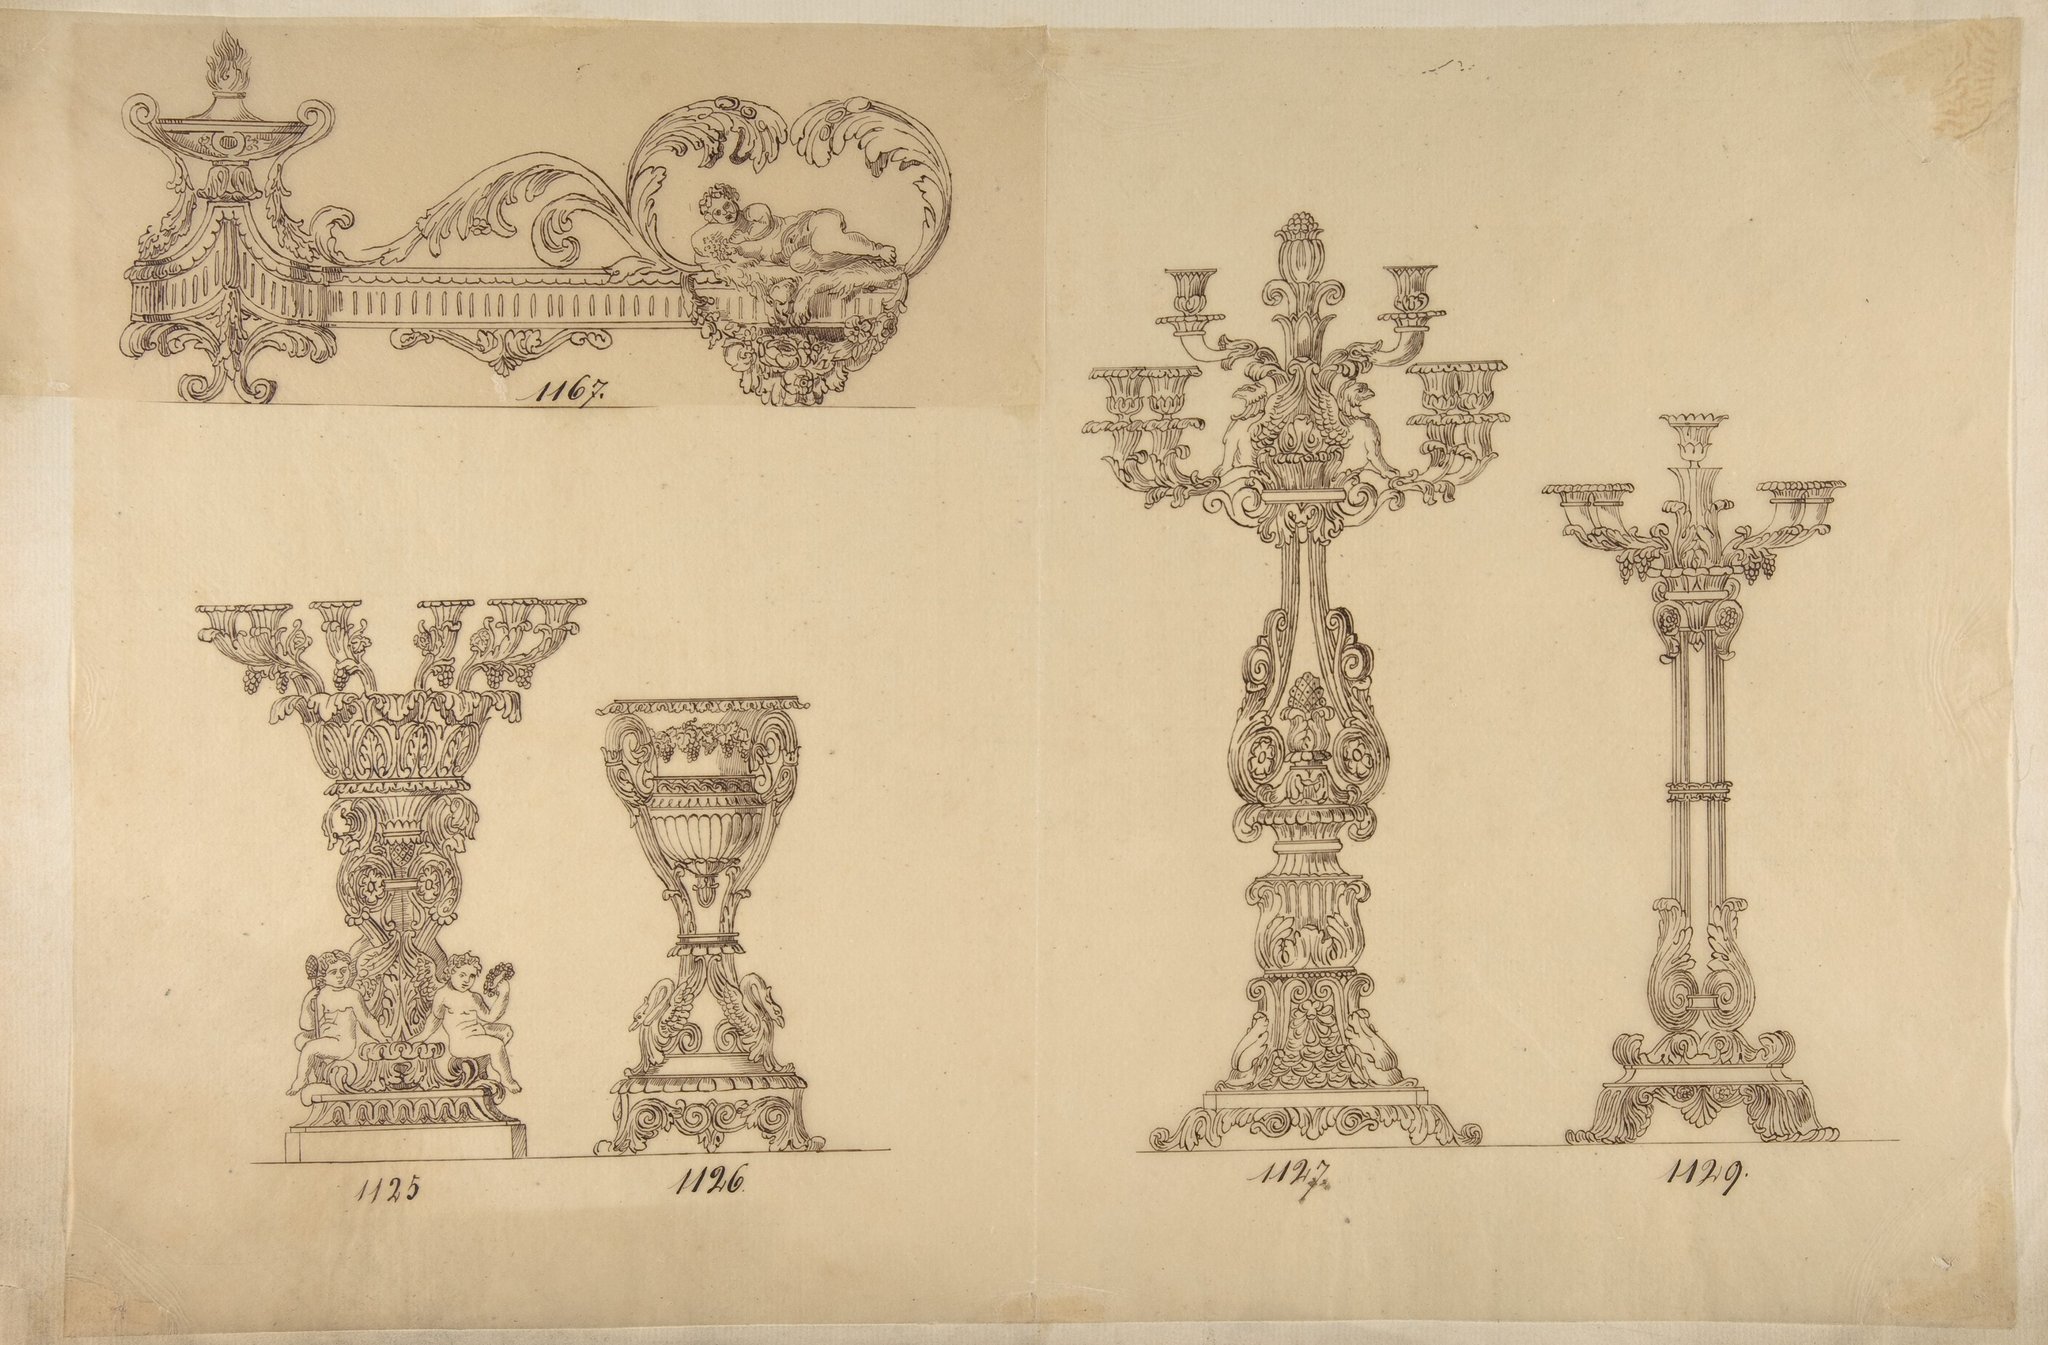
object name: drawing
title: Designs for Three Candelabras and an Urn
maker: anonymous, french, 19th century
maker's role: artist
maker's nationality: french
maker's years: 1800-1900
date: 1801-1900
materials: ink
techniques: pen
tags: candelabra,urns